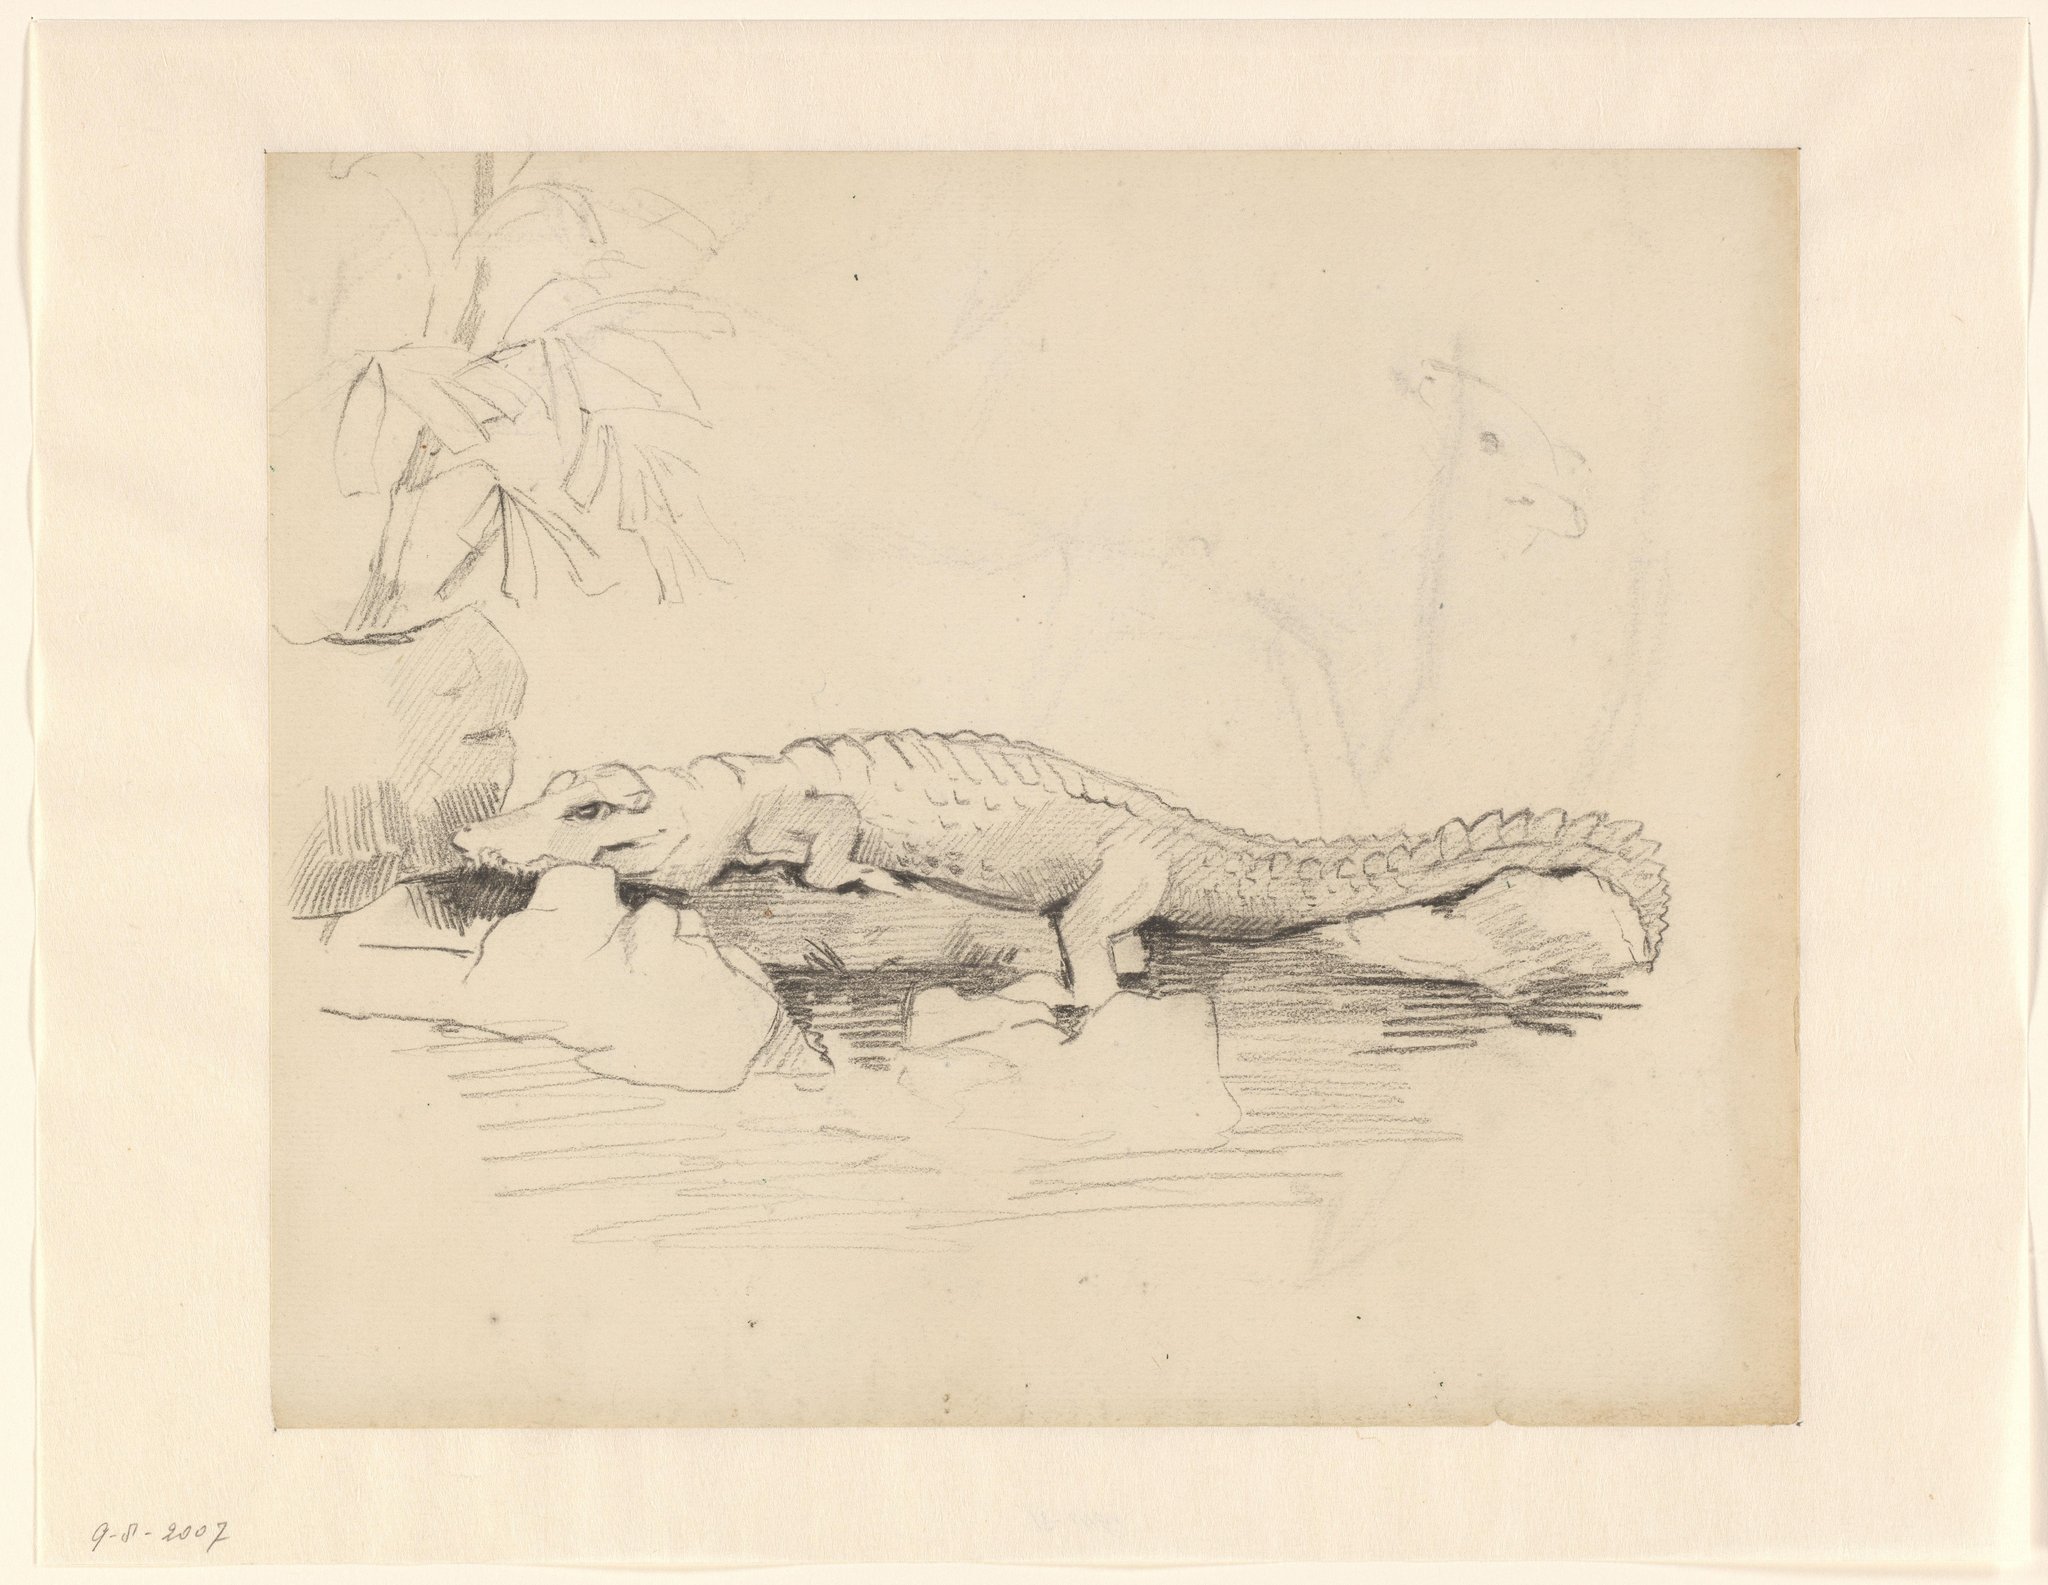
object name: drawing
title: Krokodil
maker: piet meiners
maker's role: draughtsman, painter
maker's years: 1857-1903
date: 1867-1903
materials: chalk, paper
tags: crocodiles: crocodile